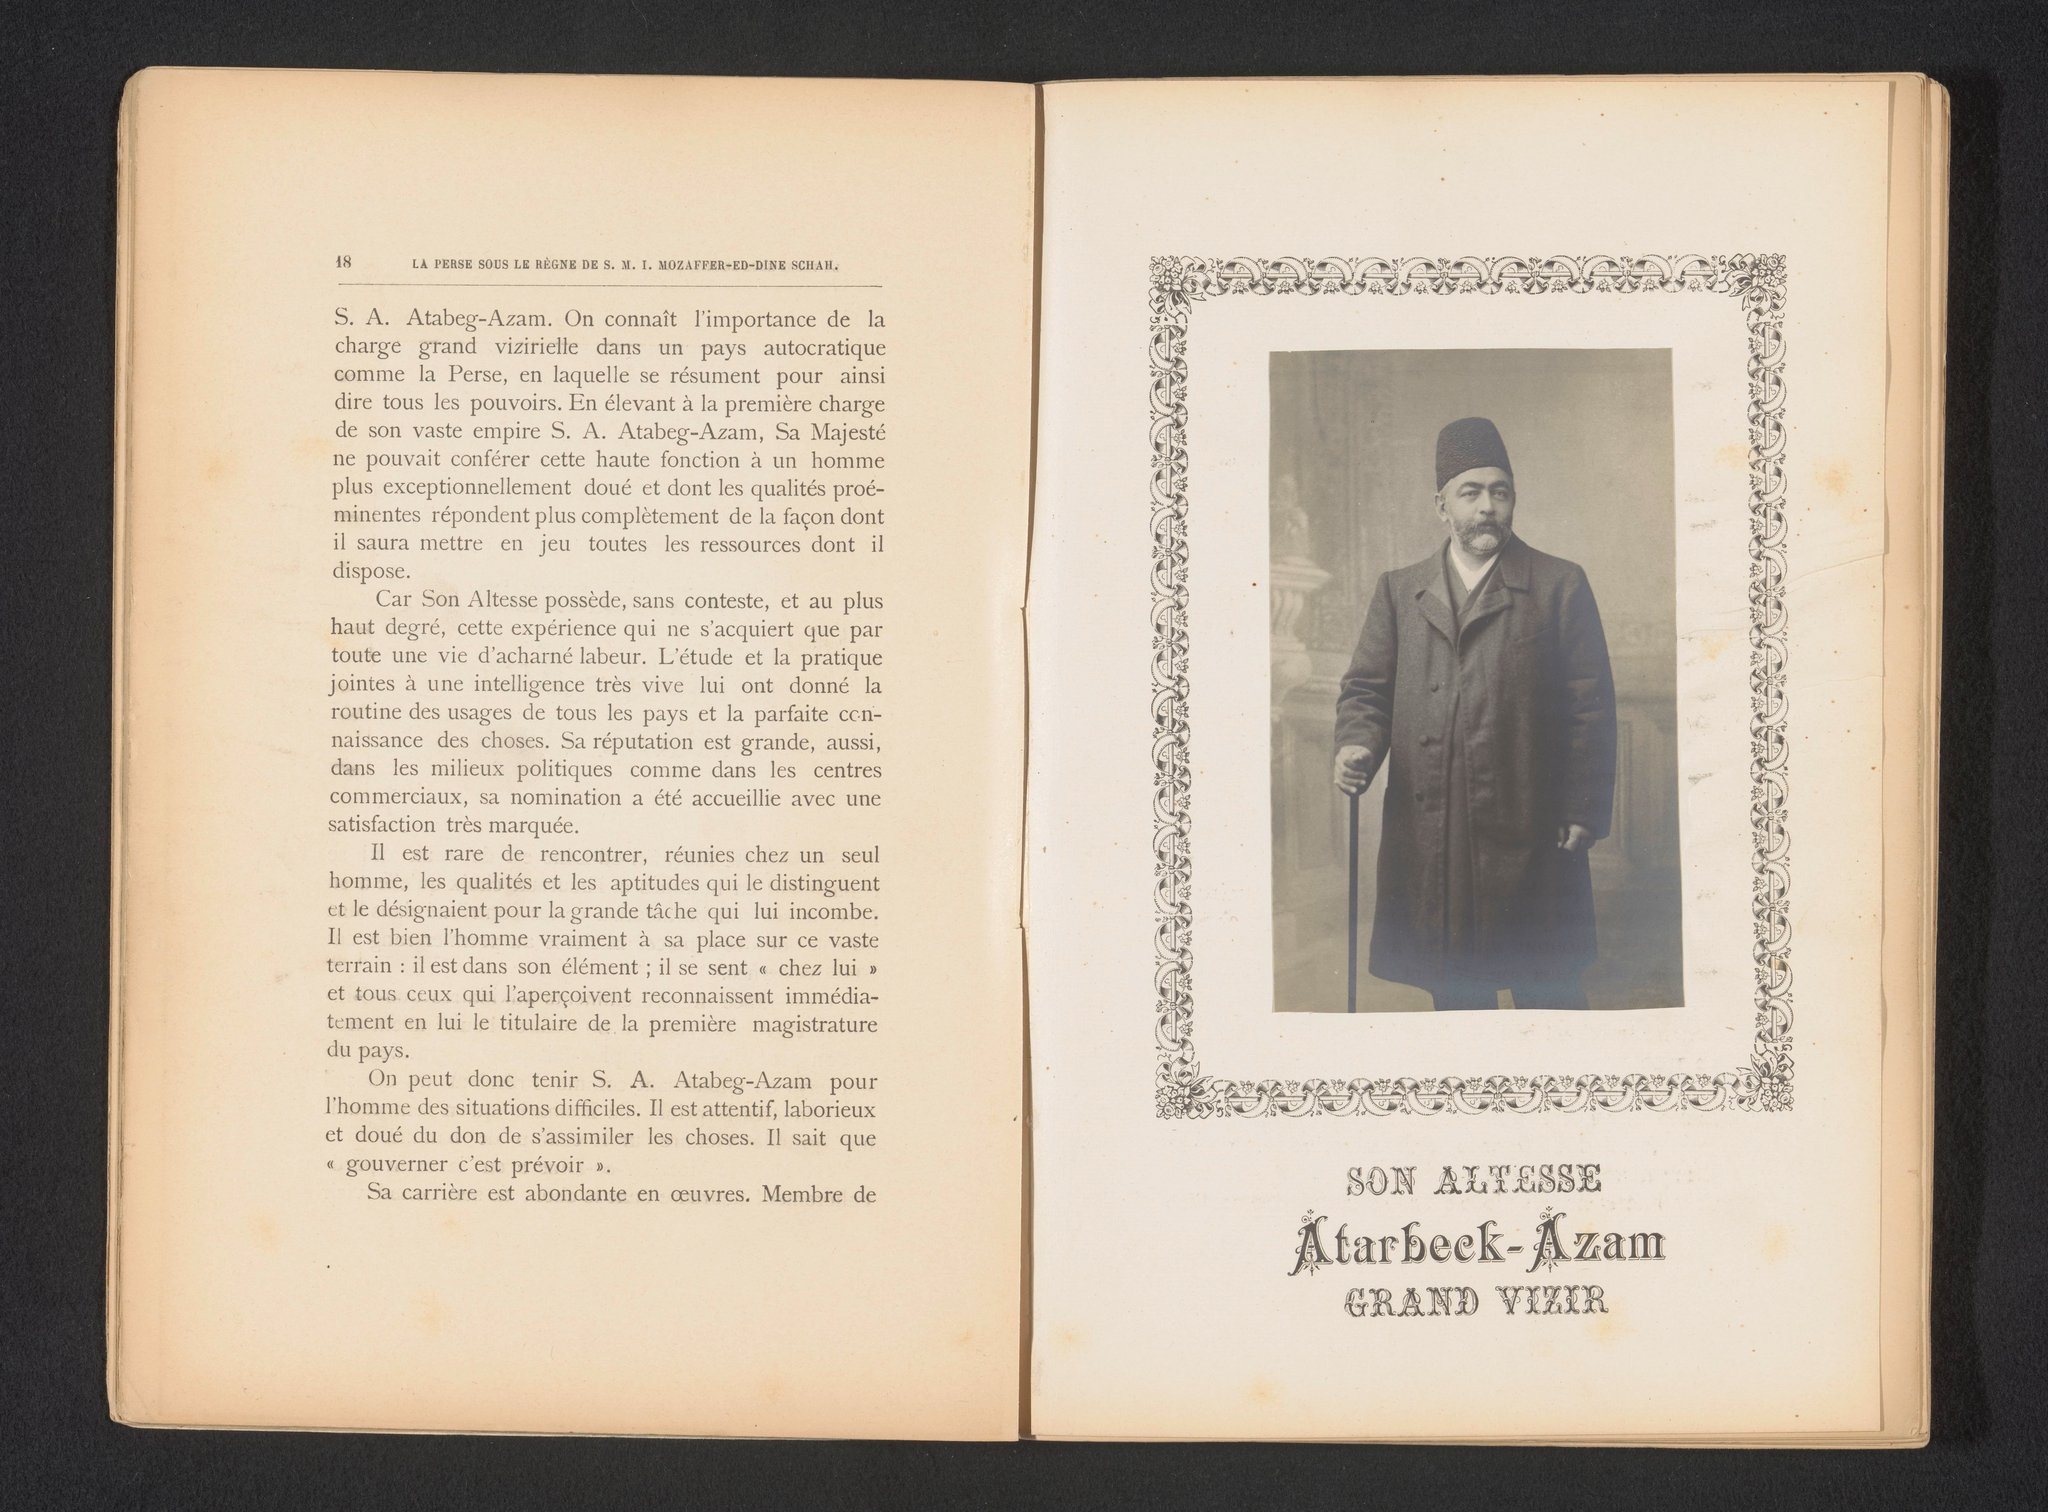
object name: page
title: Portret van de grootvizier van sjah Mozaffer ed-Din Kadjar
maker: Anonymous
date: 1897-1902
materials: photographic support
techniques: gelatin silver print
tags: historical persons not known by name